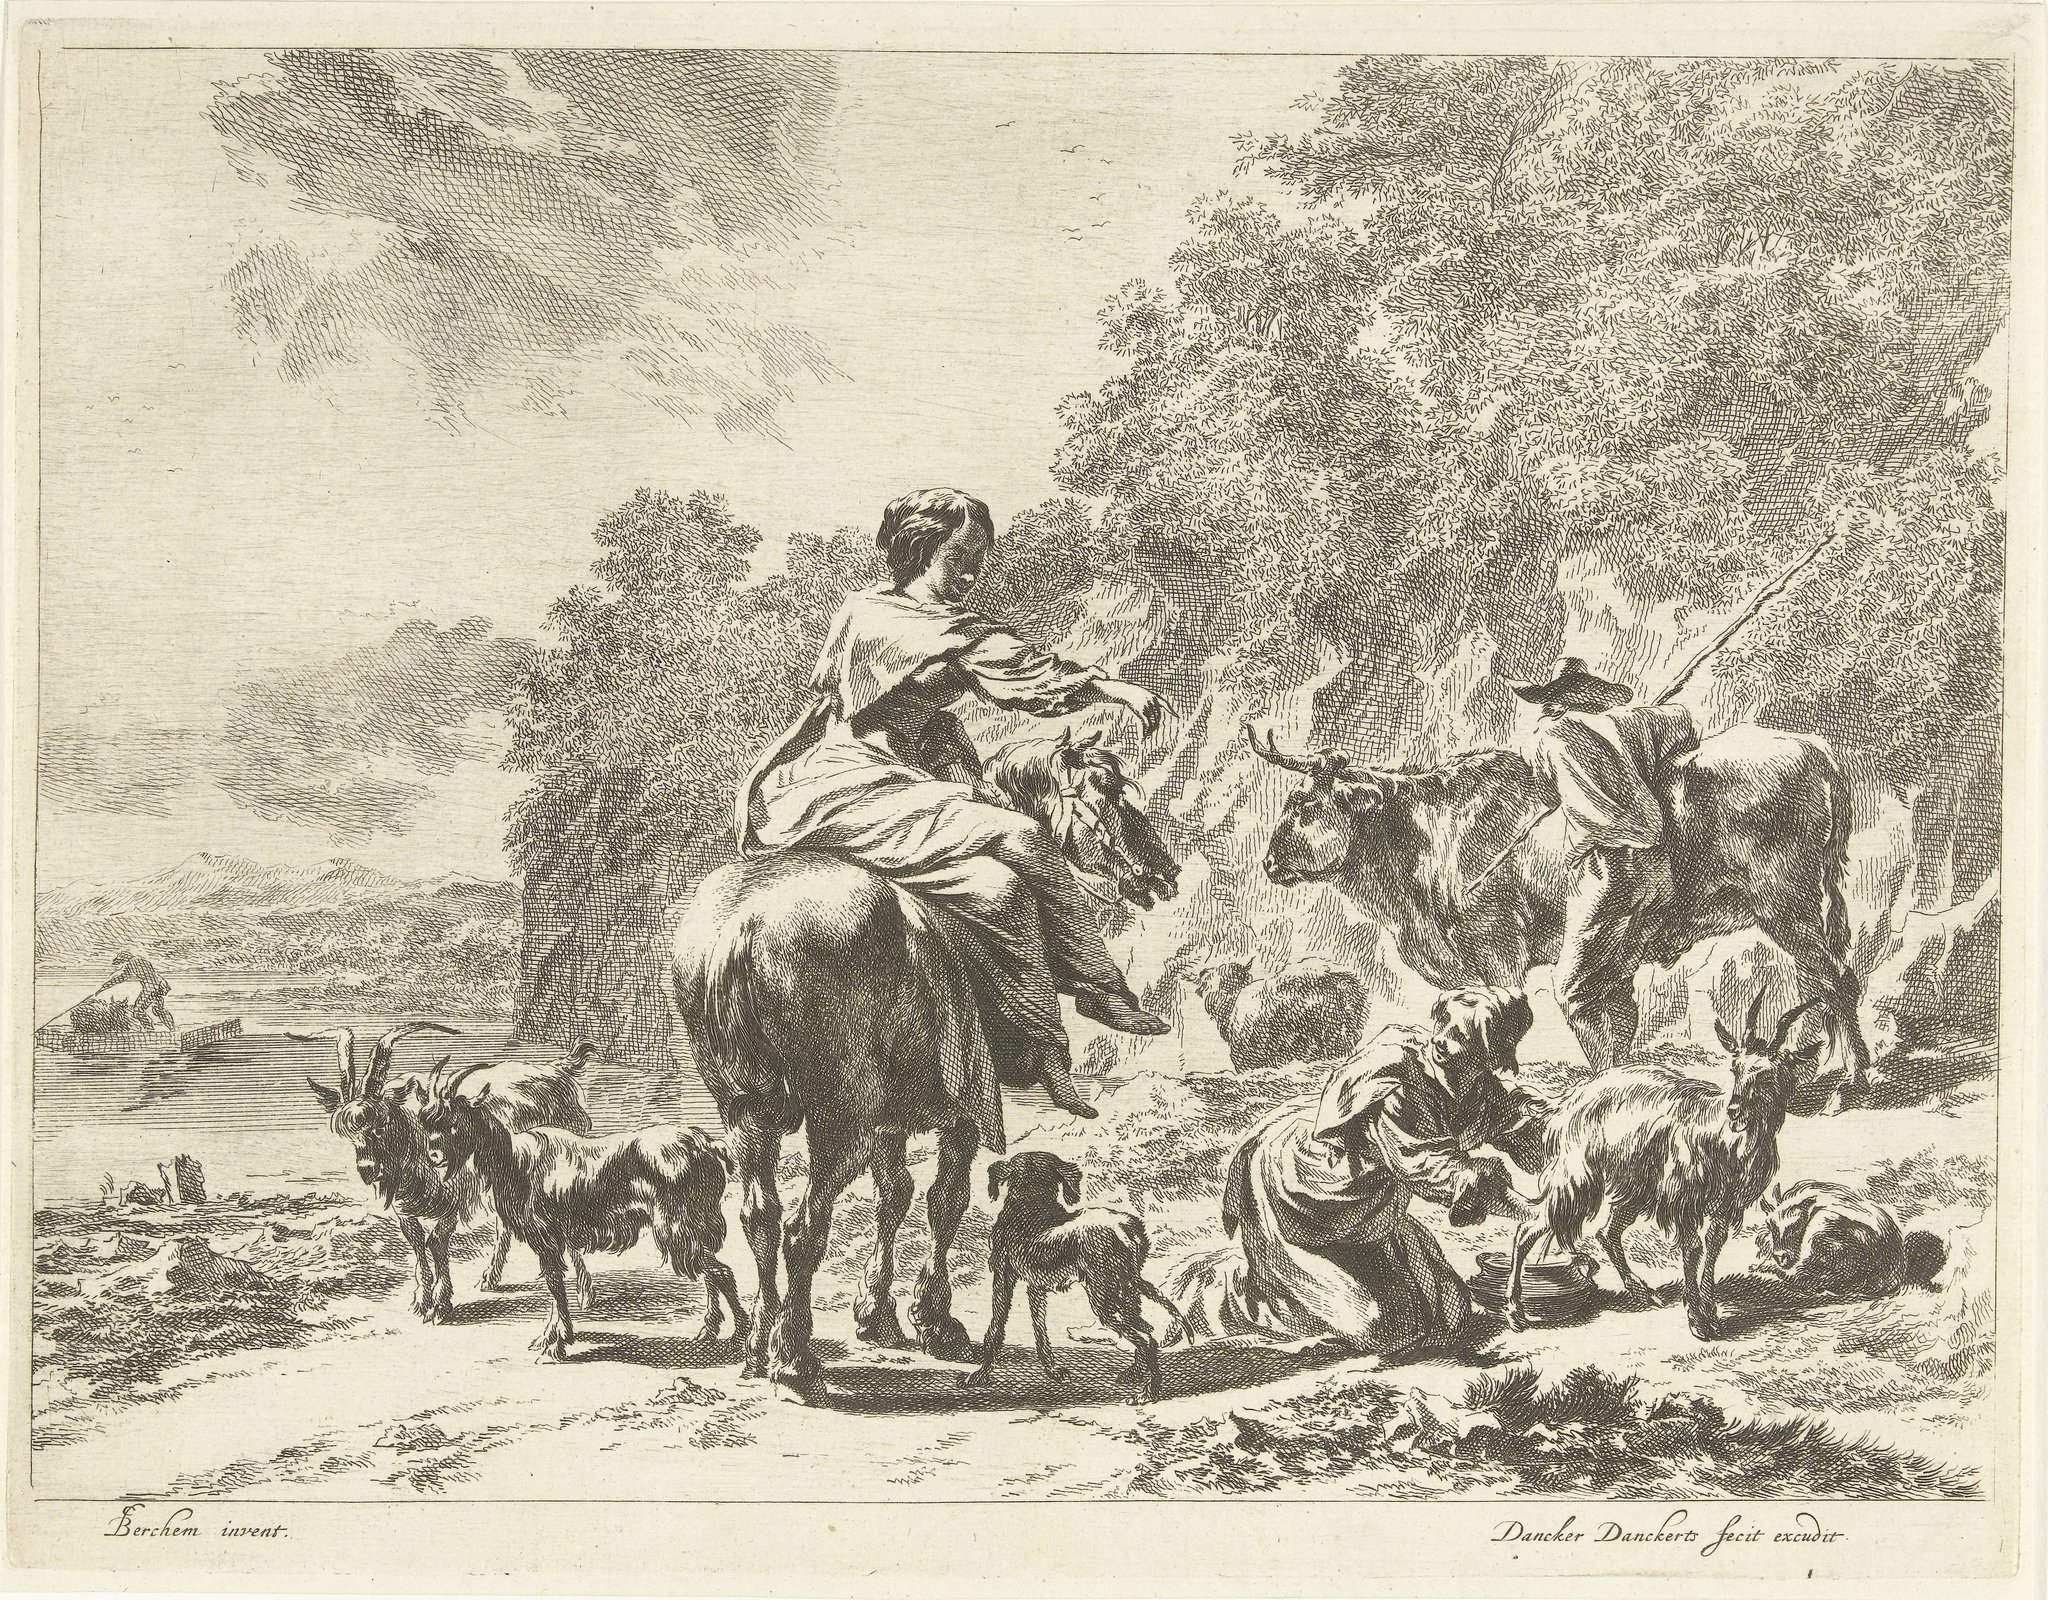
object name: print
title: Landschap met vrouw te paard en herderin die een geit melkt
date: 1643-1666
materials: paper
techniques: etching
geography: amsterdam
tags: herding, herdsman, herdswoman, shepherd, shepherdess, cowherd, etc., goat, rocks, milking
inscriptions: collector's mark: Lugt 240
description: Prent uit serie van zes landschappen naar ontwerp van Nicolaes Pietersz. Berchem. Van deze laatste prent uit de reeks zijn vier staten bekend, vergelijk inv.nr. RP-P-OB-50.021.